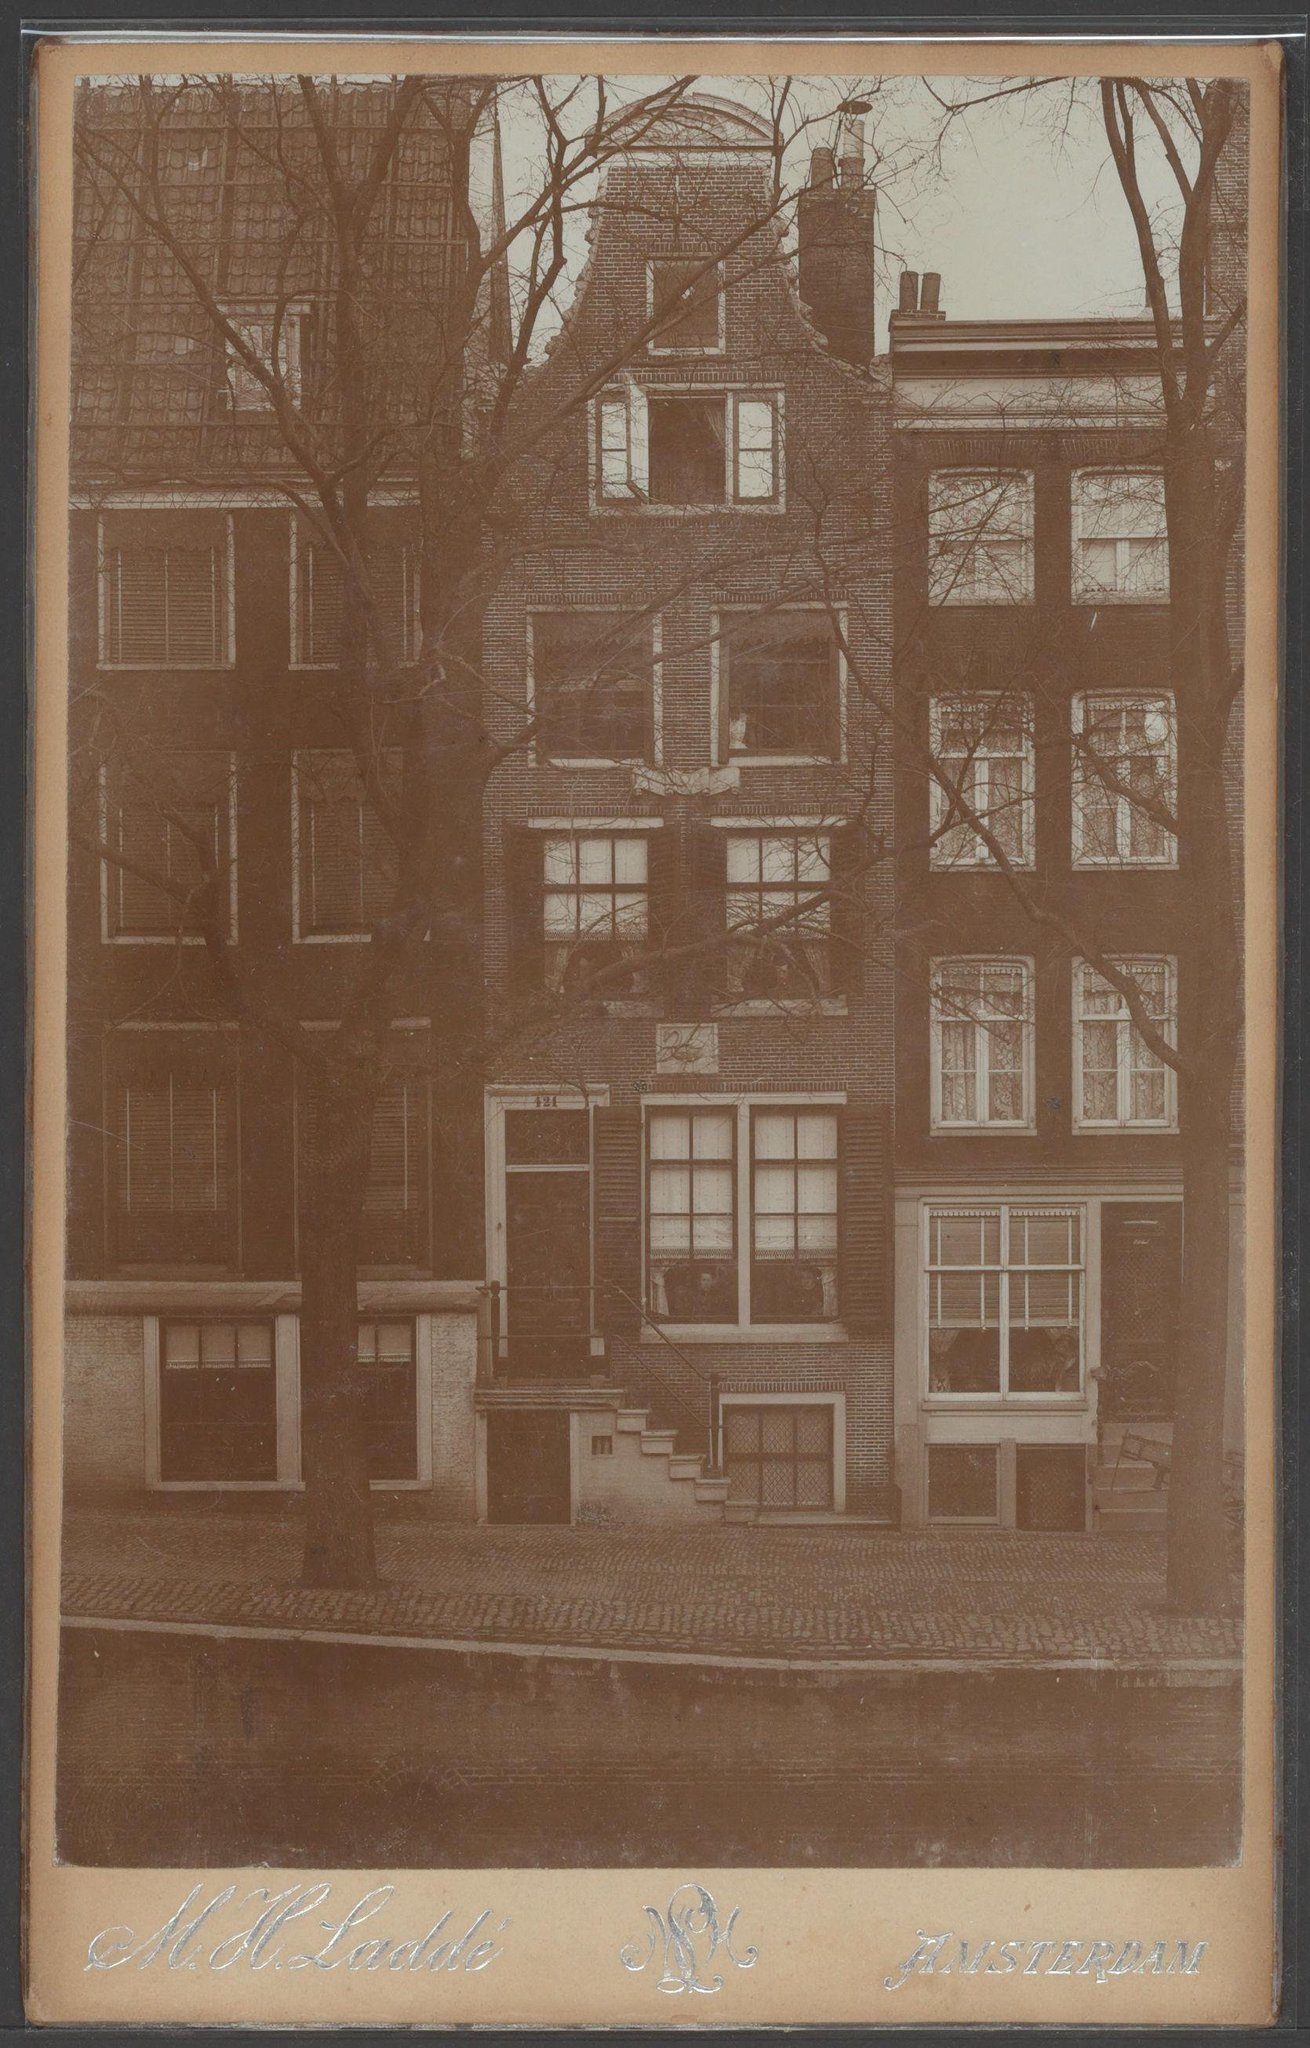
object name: photograph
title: Gezicht op de gevel van Keizersgracht 421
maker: machiel hendricus laddé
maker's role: fotograaf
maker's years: 1866-1932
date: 1892-1906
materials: paper, cardboard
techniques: collodion silver print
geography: amsterdam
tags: city-view in general; 'veduta', the usual house or row of houses, façade (of house or building)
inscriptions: collector's mark: ‘9.50’ Lugt 1641b, inscription: ‘Keizersgracht 421 / 1893-1903 door / ons bewoond / Juni 1911 afgebroken / Familie L M Baale’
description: Onderwerpsrubriek binnen de Atlas Amsterdam: Kadijksplein, Karthuizerkerkhof, Kattegat, Kattenburg, Kapelsteeg O.Z., Enge Kerksteeg, Kerkstraat, Kinkerstraat, Kolk O.Z., Koningsplein, Kromboomsloot [Krom Boomssloot], Kostverlorenkade, Kwakersdwarspad, Kalverstraat, Keizersgracht (v.d. Brouwersgracht – Amstel), Klerensloot (Gedempte), Klimopstraat, Kloveniersburgwal, Kraansluis.